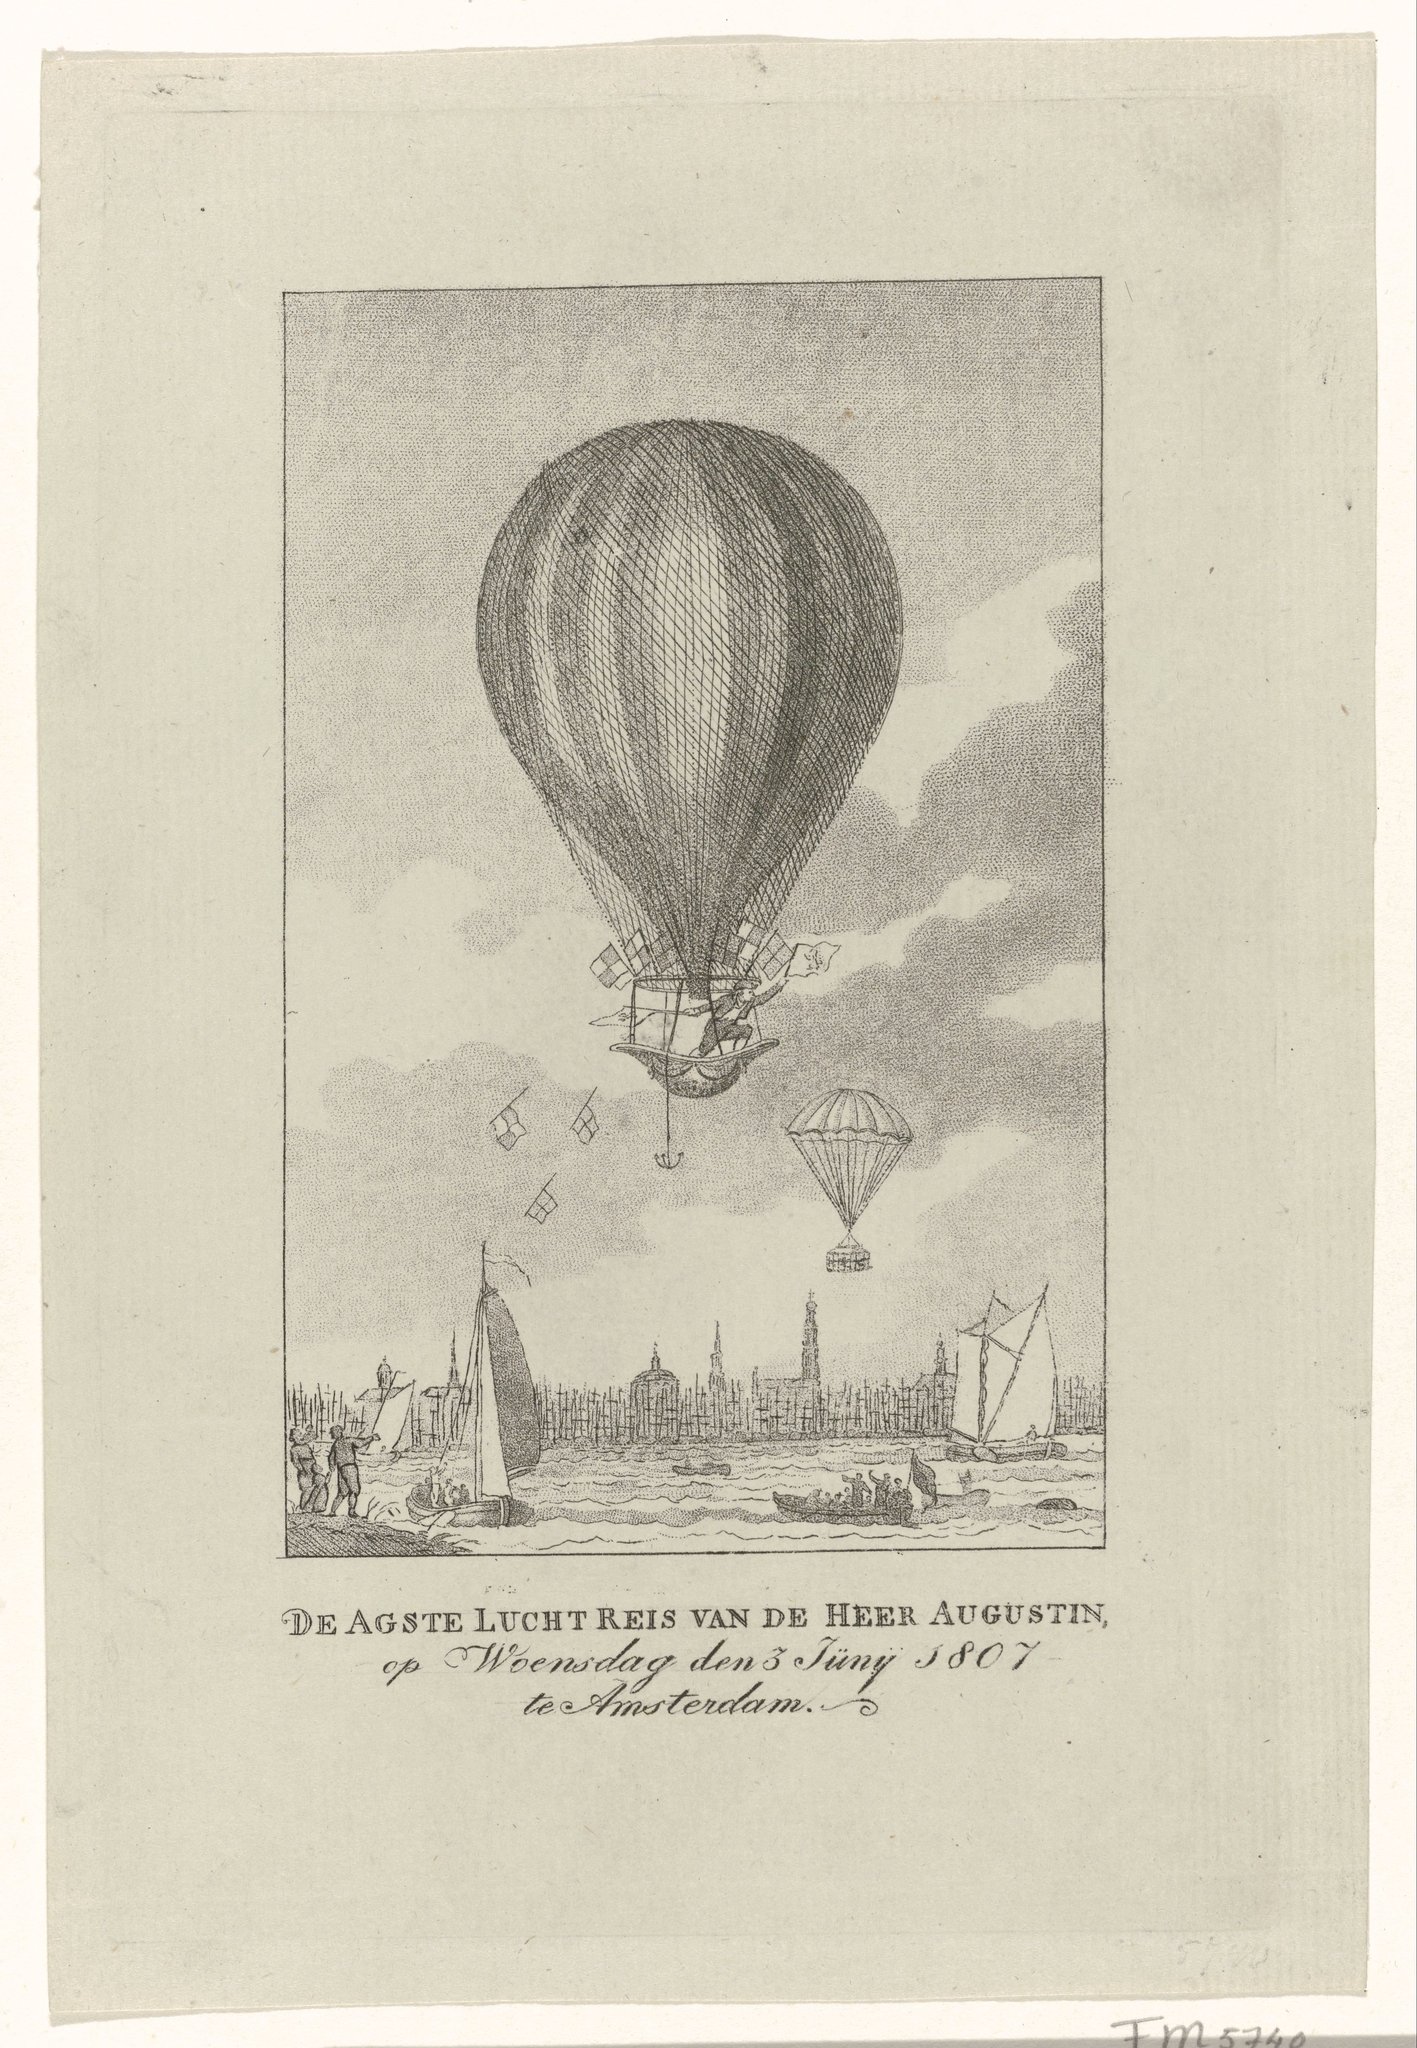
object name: print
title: De Agste Lucht reis van de Heer Augustin, op Woensdag den 3 Juny 1807 te Amsterdam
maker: Anonymous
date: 1807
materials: paper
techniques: etching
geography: netherlands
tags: balloon (aviation)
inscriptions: collector's mark: Lugt 2228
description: De achtste reis per luchtballon van de heer Augustin of Augustijn op 3 juni 1807. Gezicht van de luchtballon boven het IJ te Amsterdam. Augustin gooit vanuit de ballon vlaggetjes naar beneden, in het verschiet een tweede luchtballon.